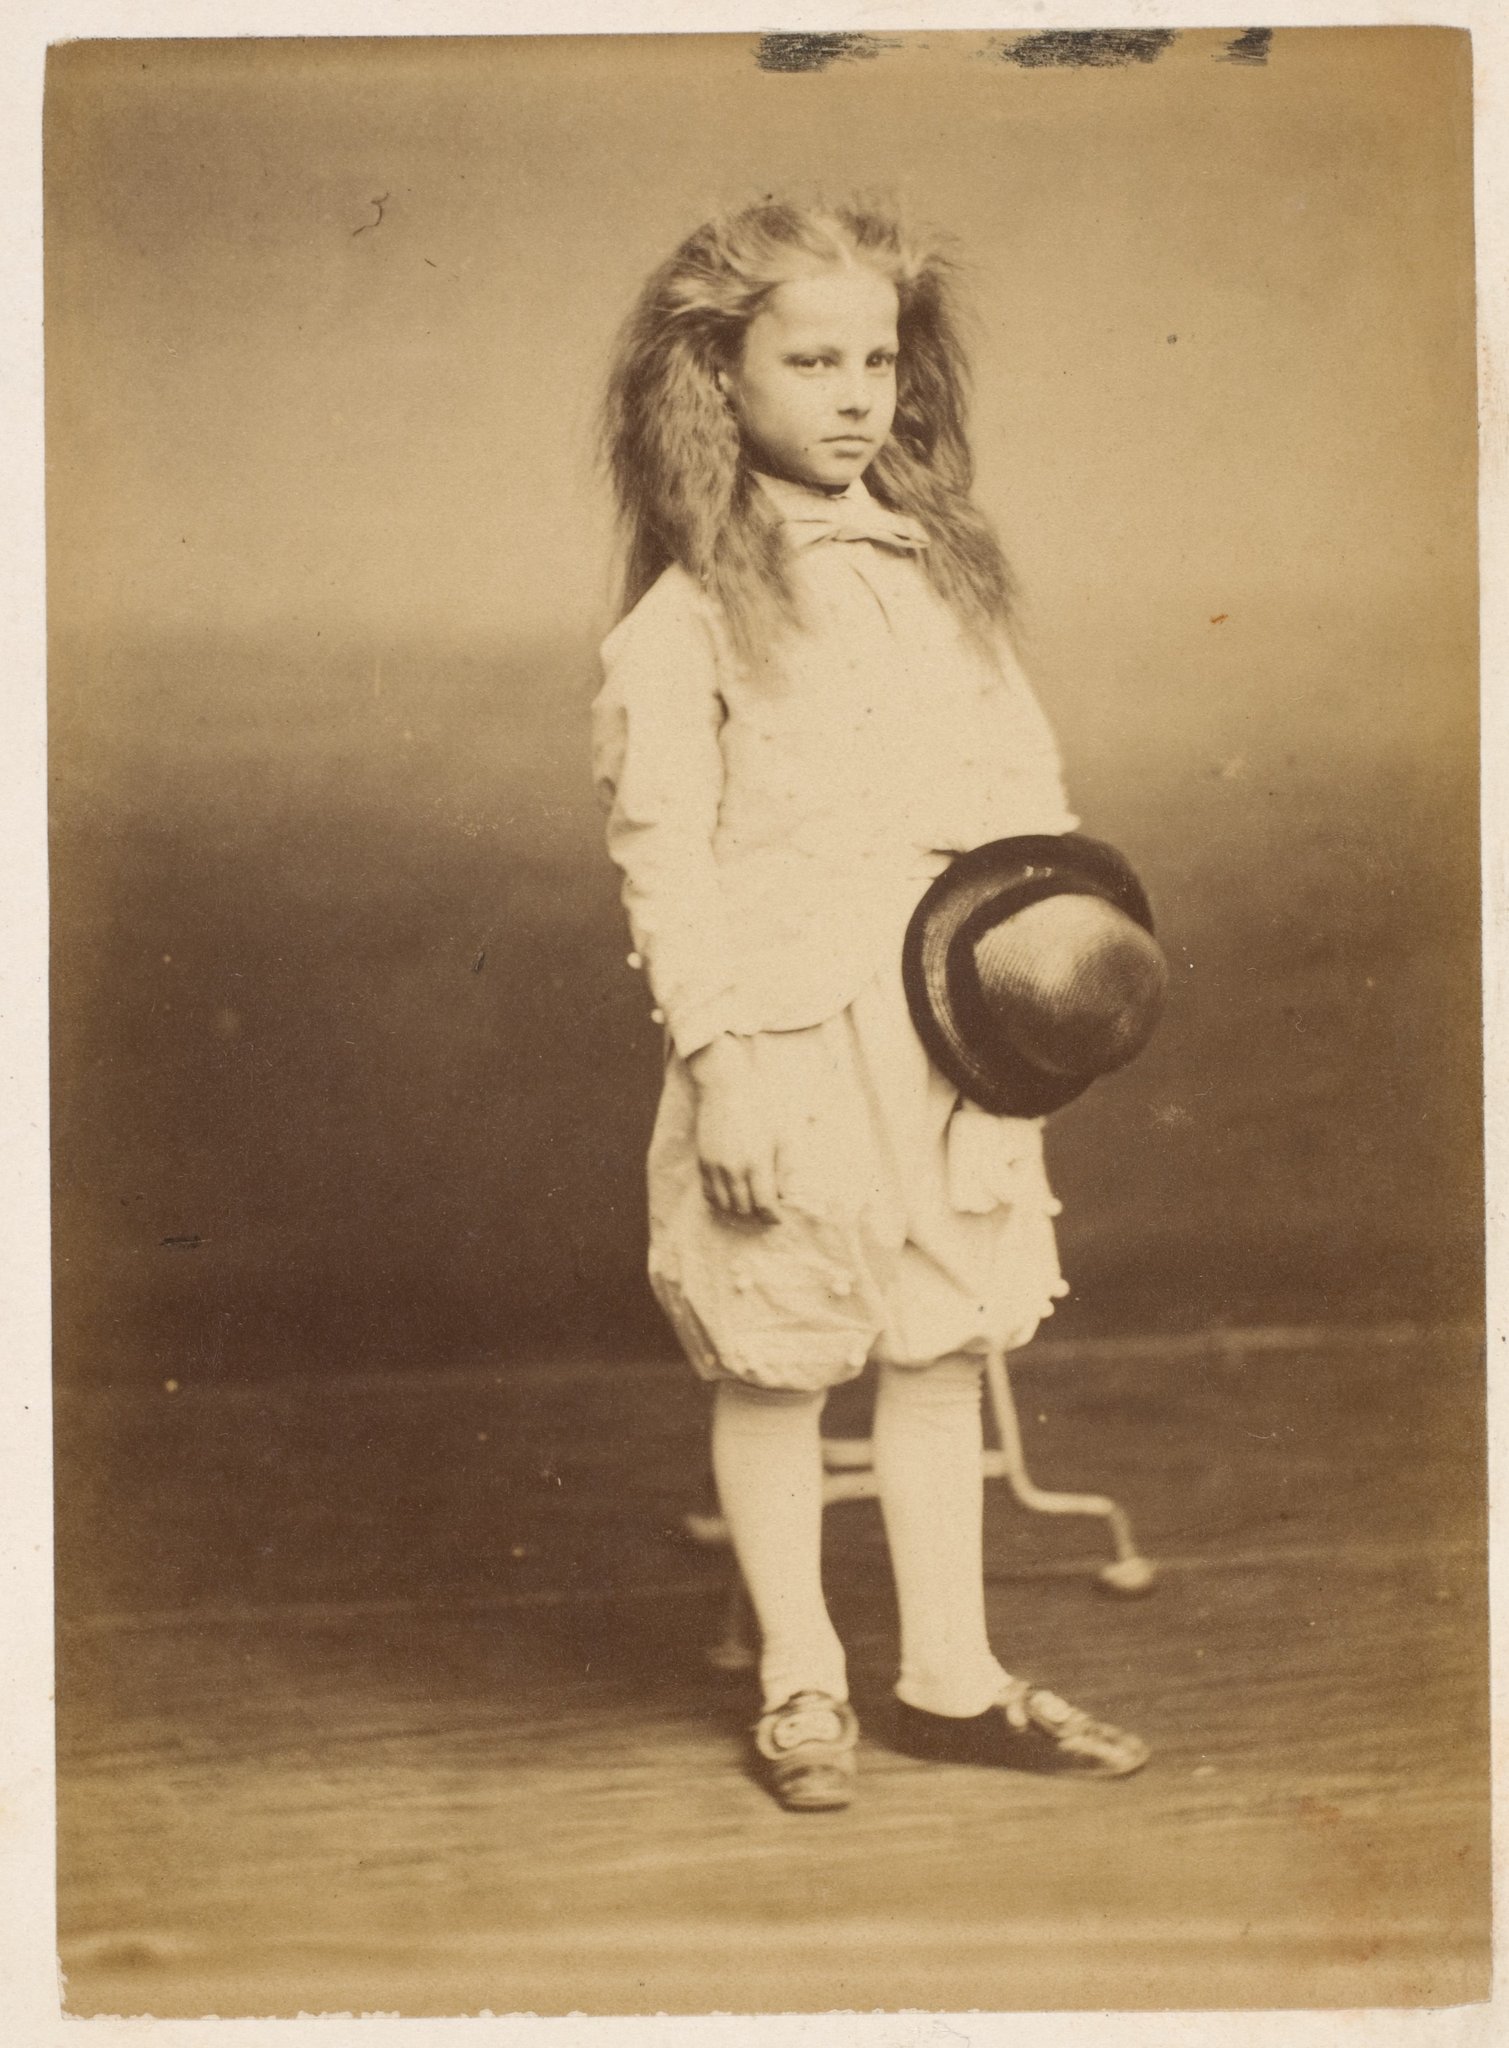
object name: photograph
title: L'Enfant blanc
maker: pierre-louis pierson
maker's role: artist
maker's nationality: french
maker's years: 1822-1913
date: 1860-1869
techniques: albumen silver print, glass negative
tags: girls,portraits